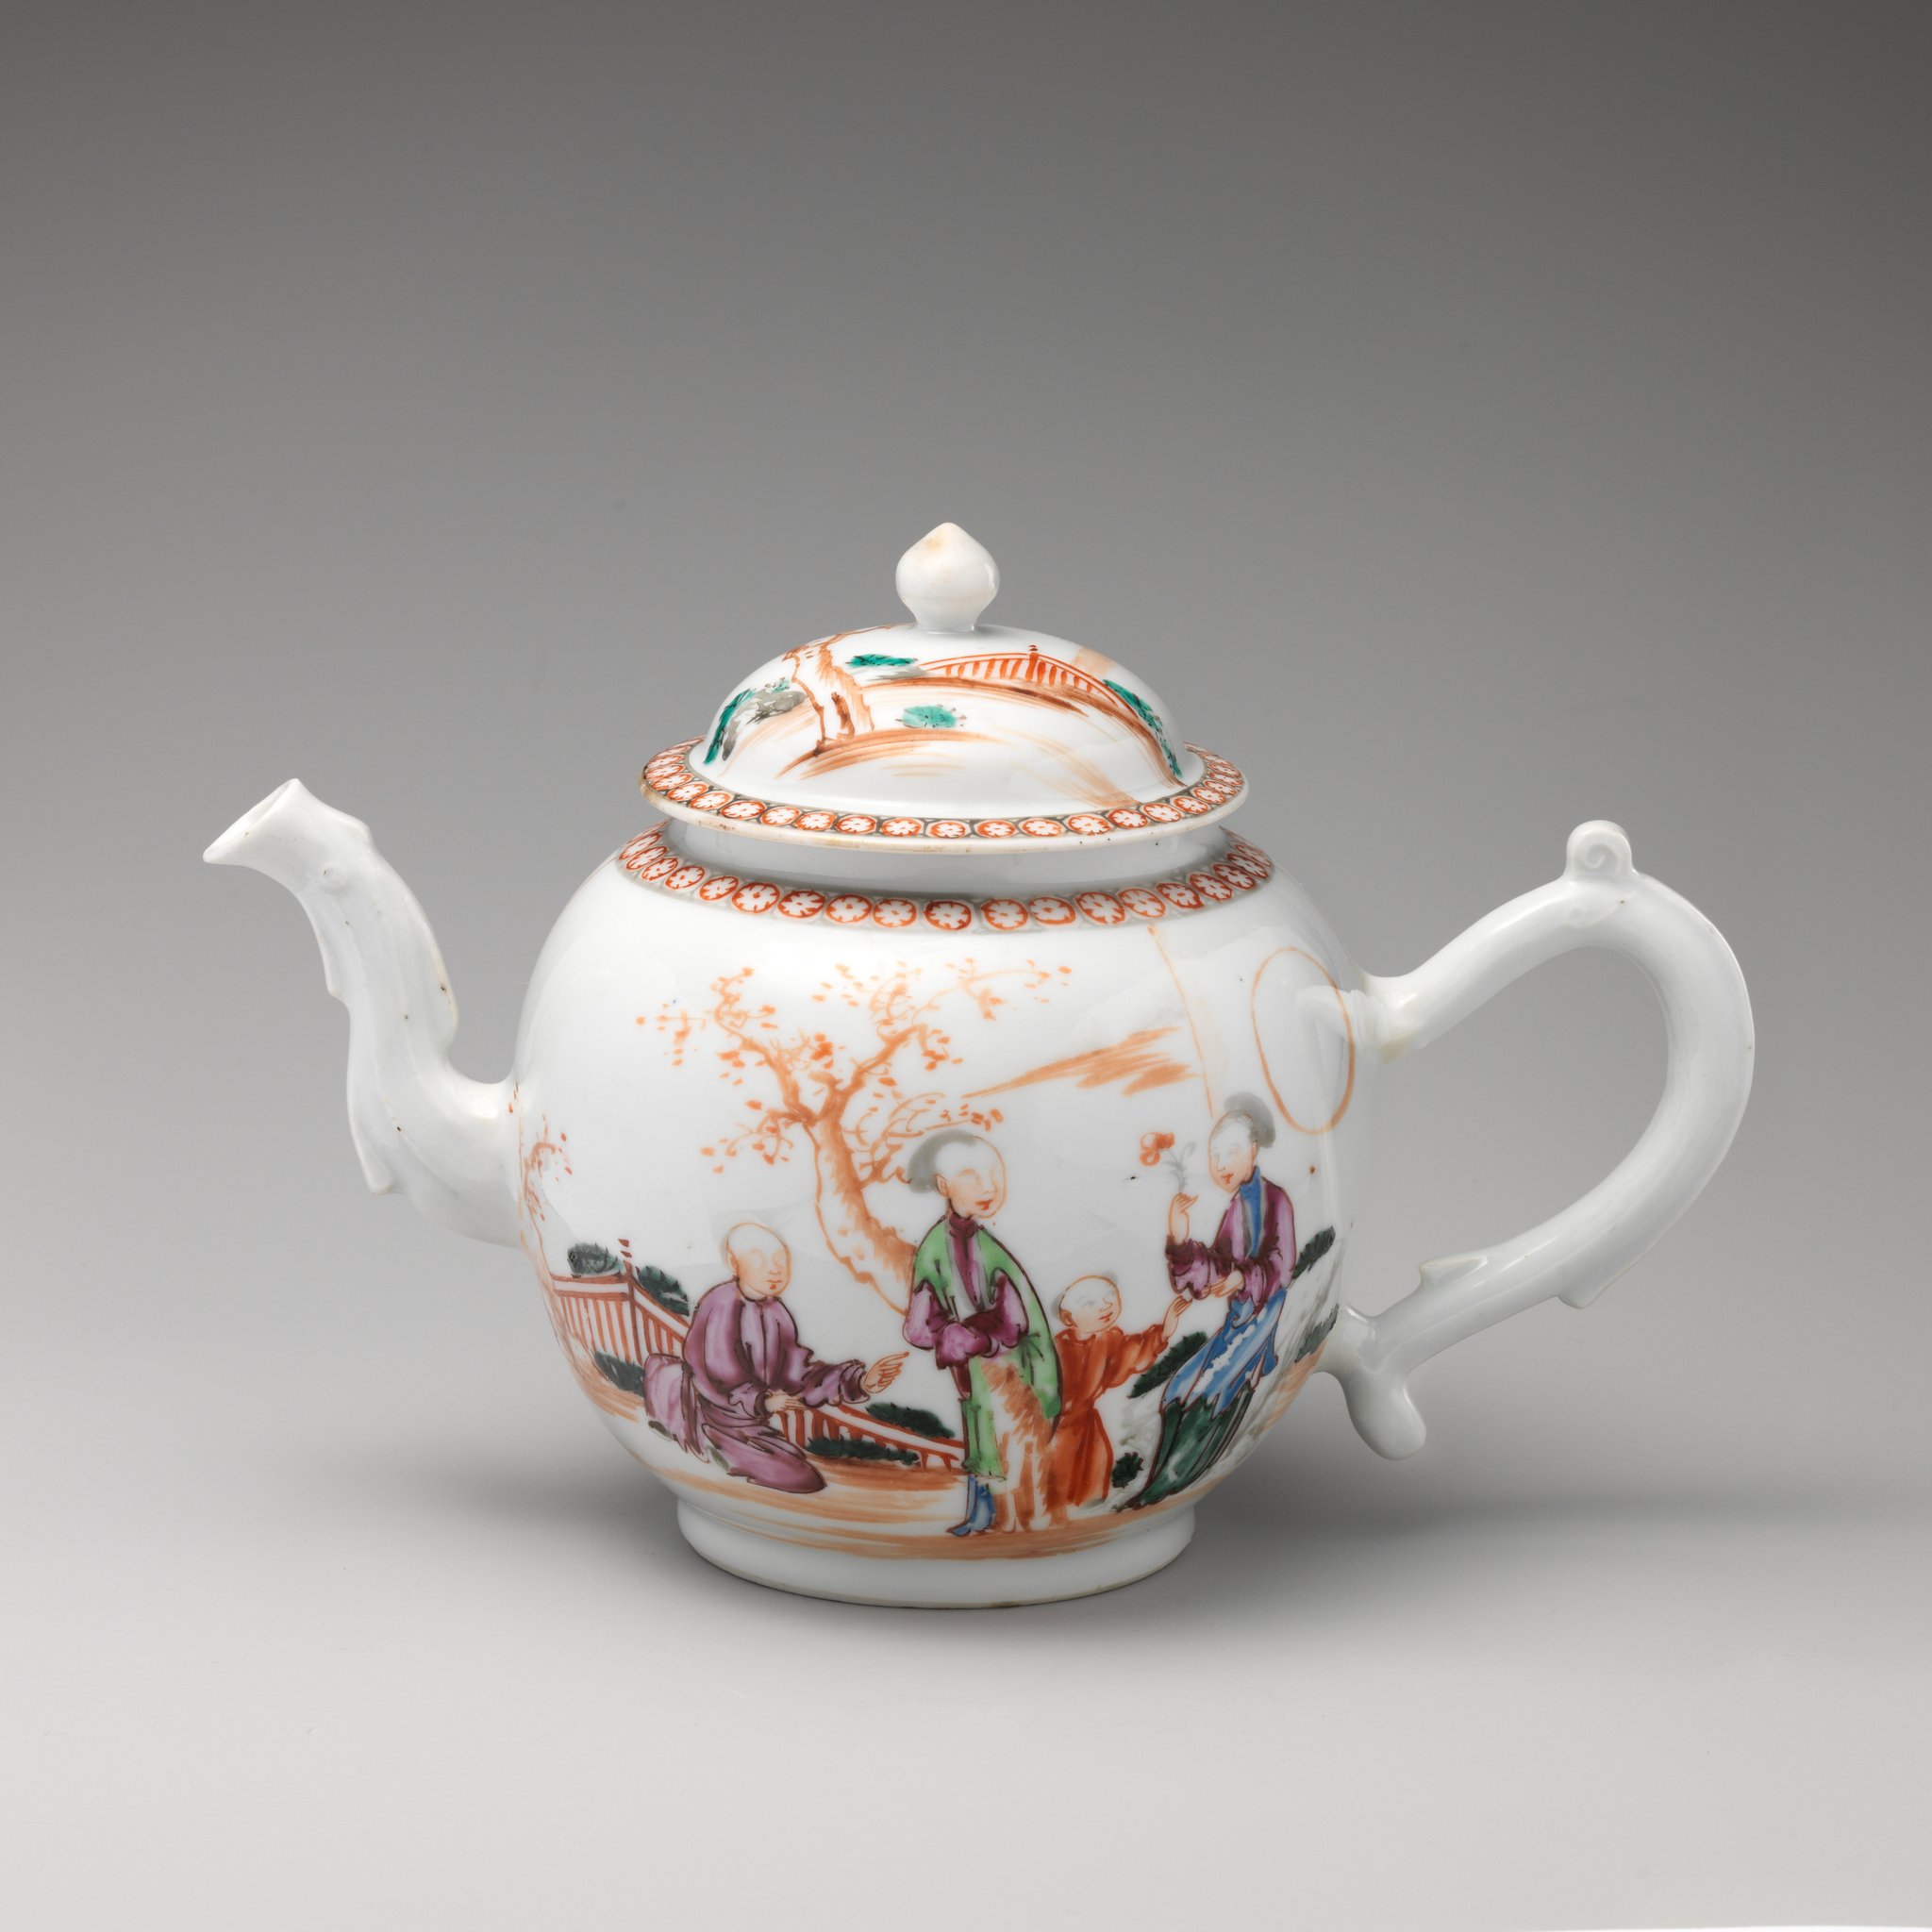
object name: teapot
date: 1770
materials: enamel, hard paste porcelain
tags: children,men,women